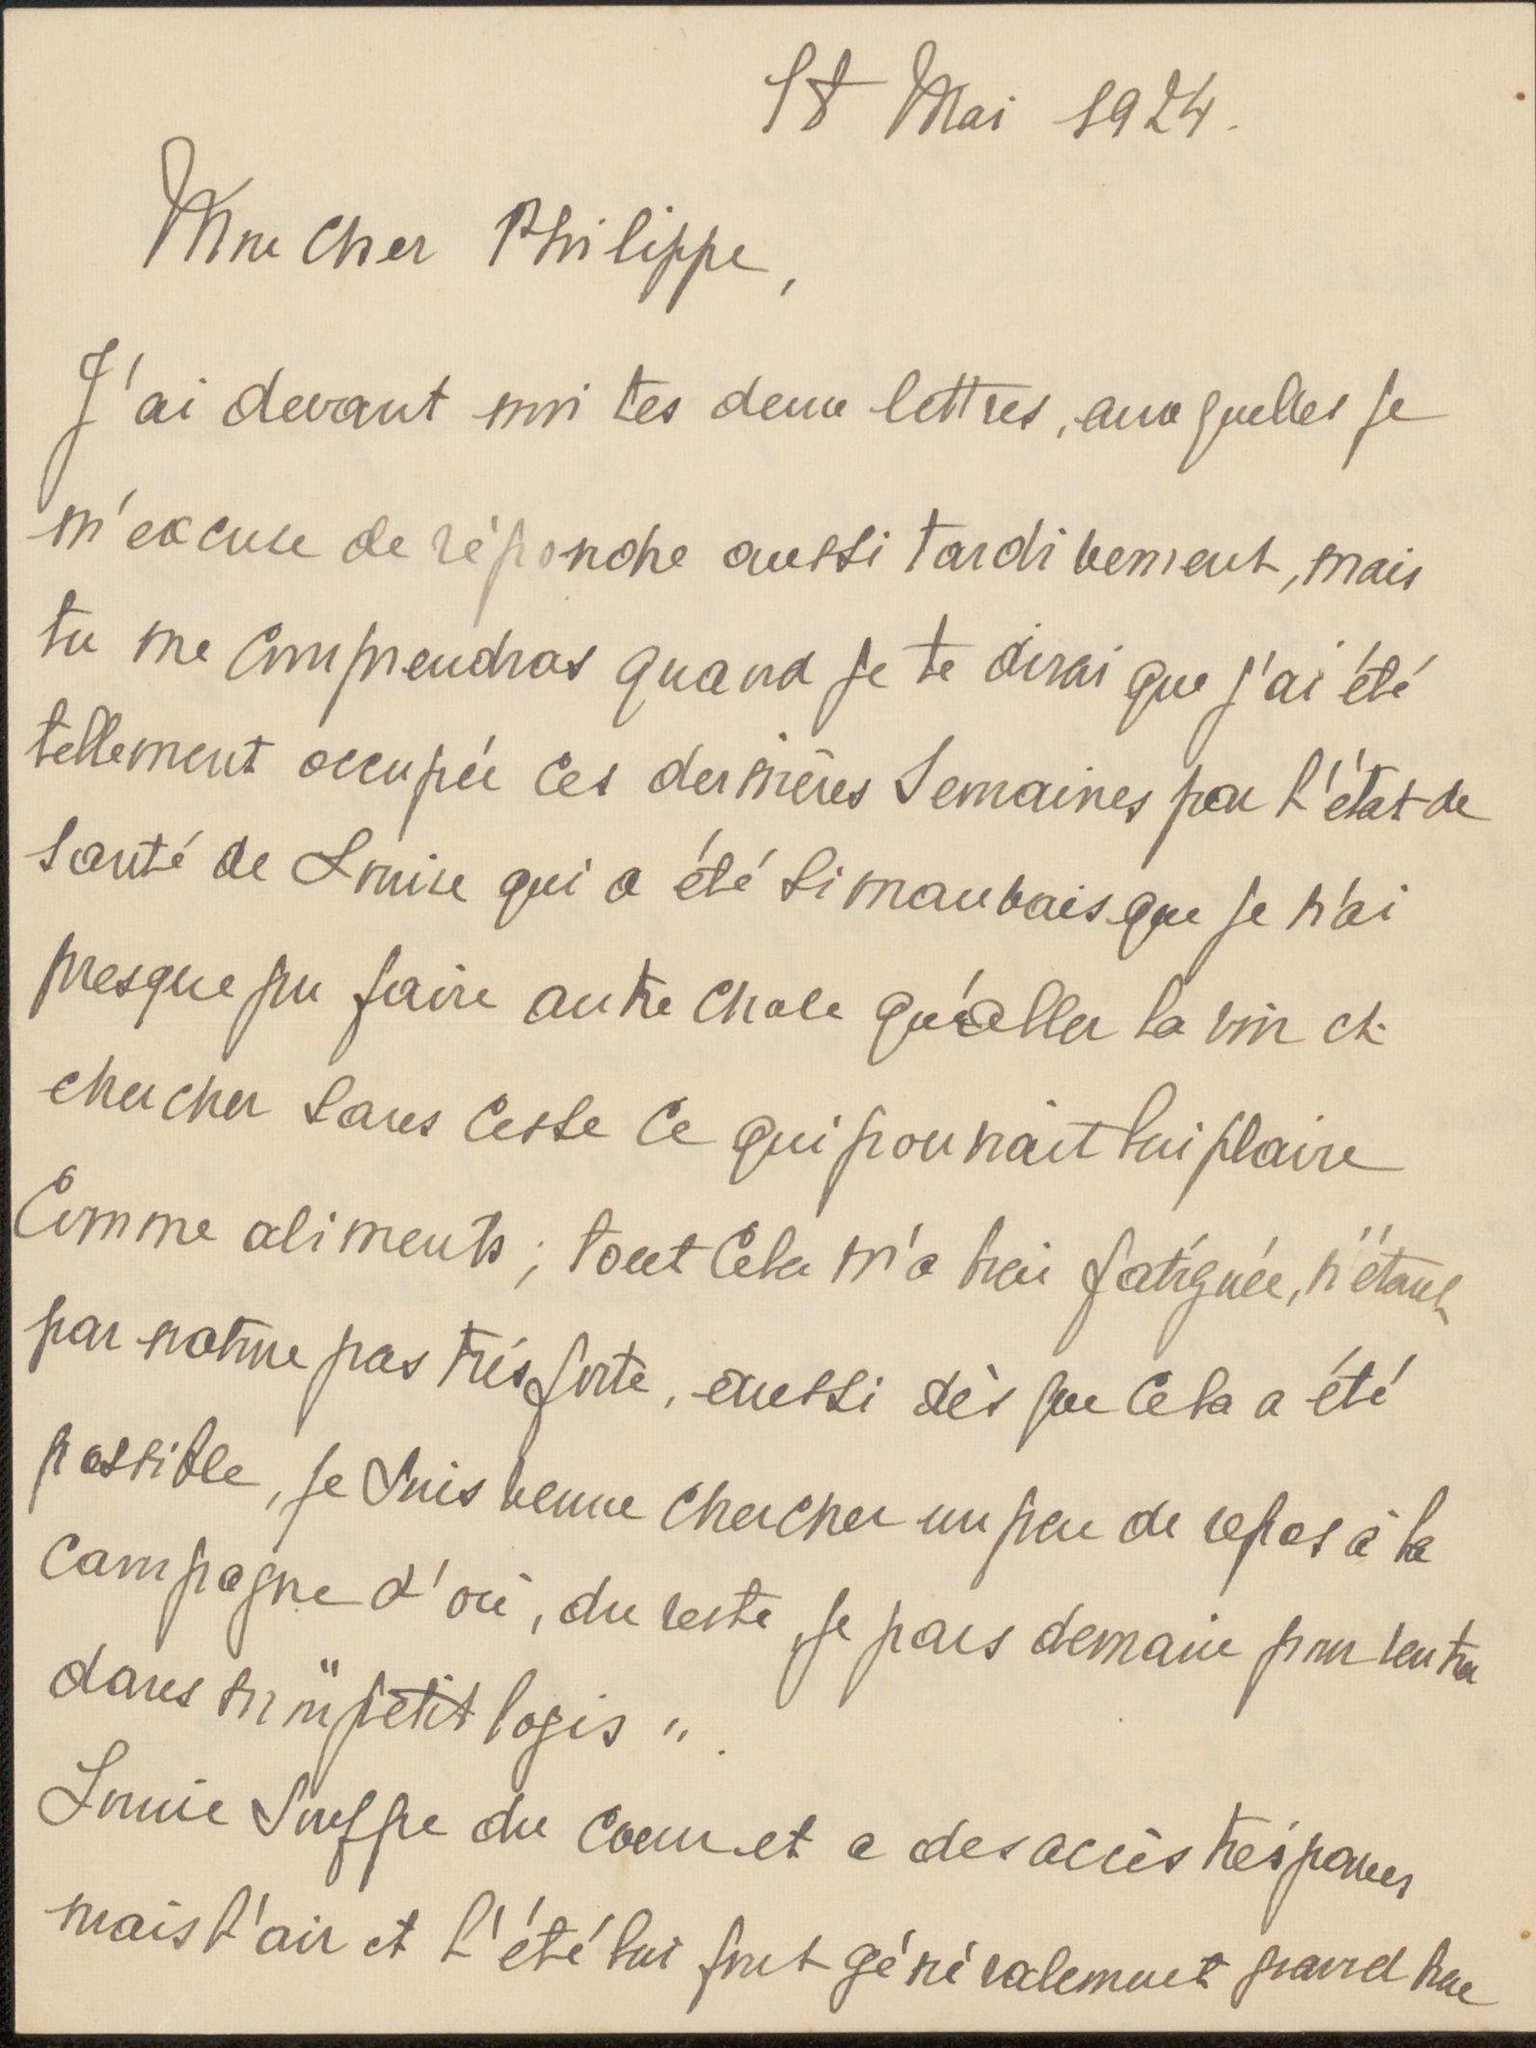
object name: letter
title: Brief aan Philip Zilcken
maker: marguerite stevens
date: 1924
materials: ink, paper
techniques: pen, writing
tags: draughtsman, philip zilcken, drawing, exhibition ~ art, brussels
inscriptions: collector's mark: ‘RPK’